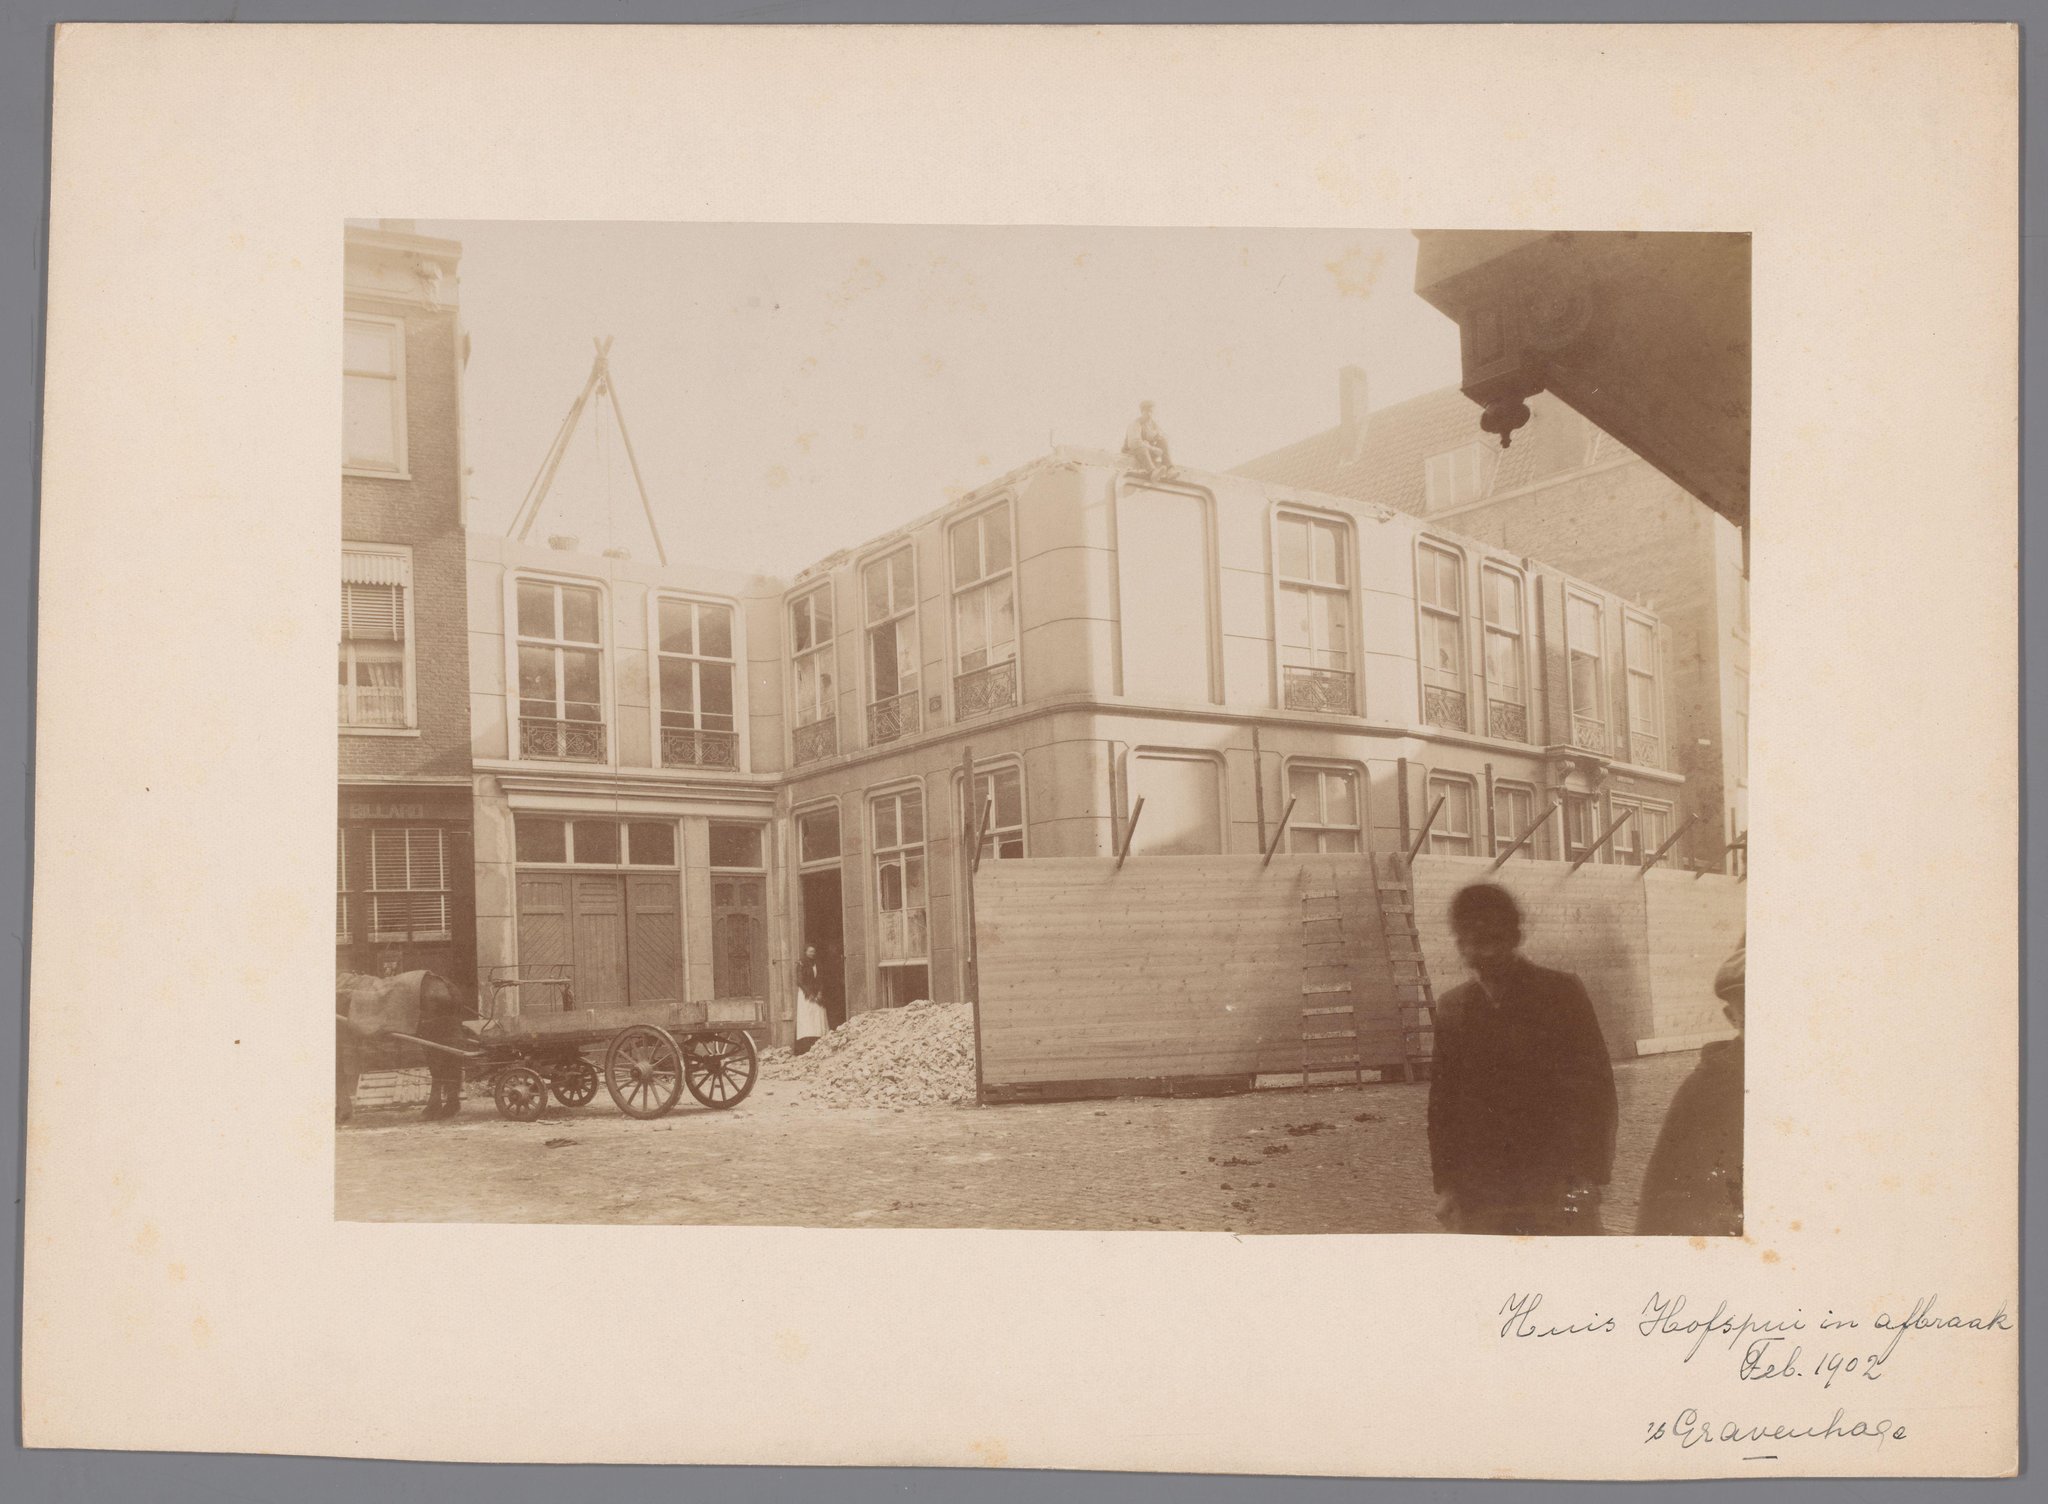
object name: photograph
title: Gezicht op een woning in afbraak te Den Haag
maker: anoniem (monumentenzorg)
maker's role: fotograaf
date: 1902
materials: cardboard, photographic support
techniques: albumen print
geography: the hague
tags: façade (of house or building), street (+ city(-scape) with figures, staffage), the hague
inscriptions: annotation: ‘'s Gravenhage (Z.H.)/ Hofspui - huis/ februari 1902’, annotation: ‘Huis Hofspui in afbraak/ Feb. 1902/ s' Gravenhage’, collector's mark: Lugt 2228